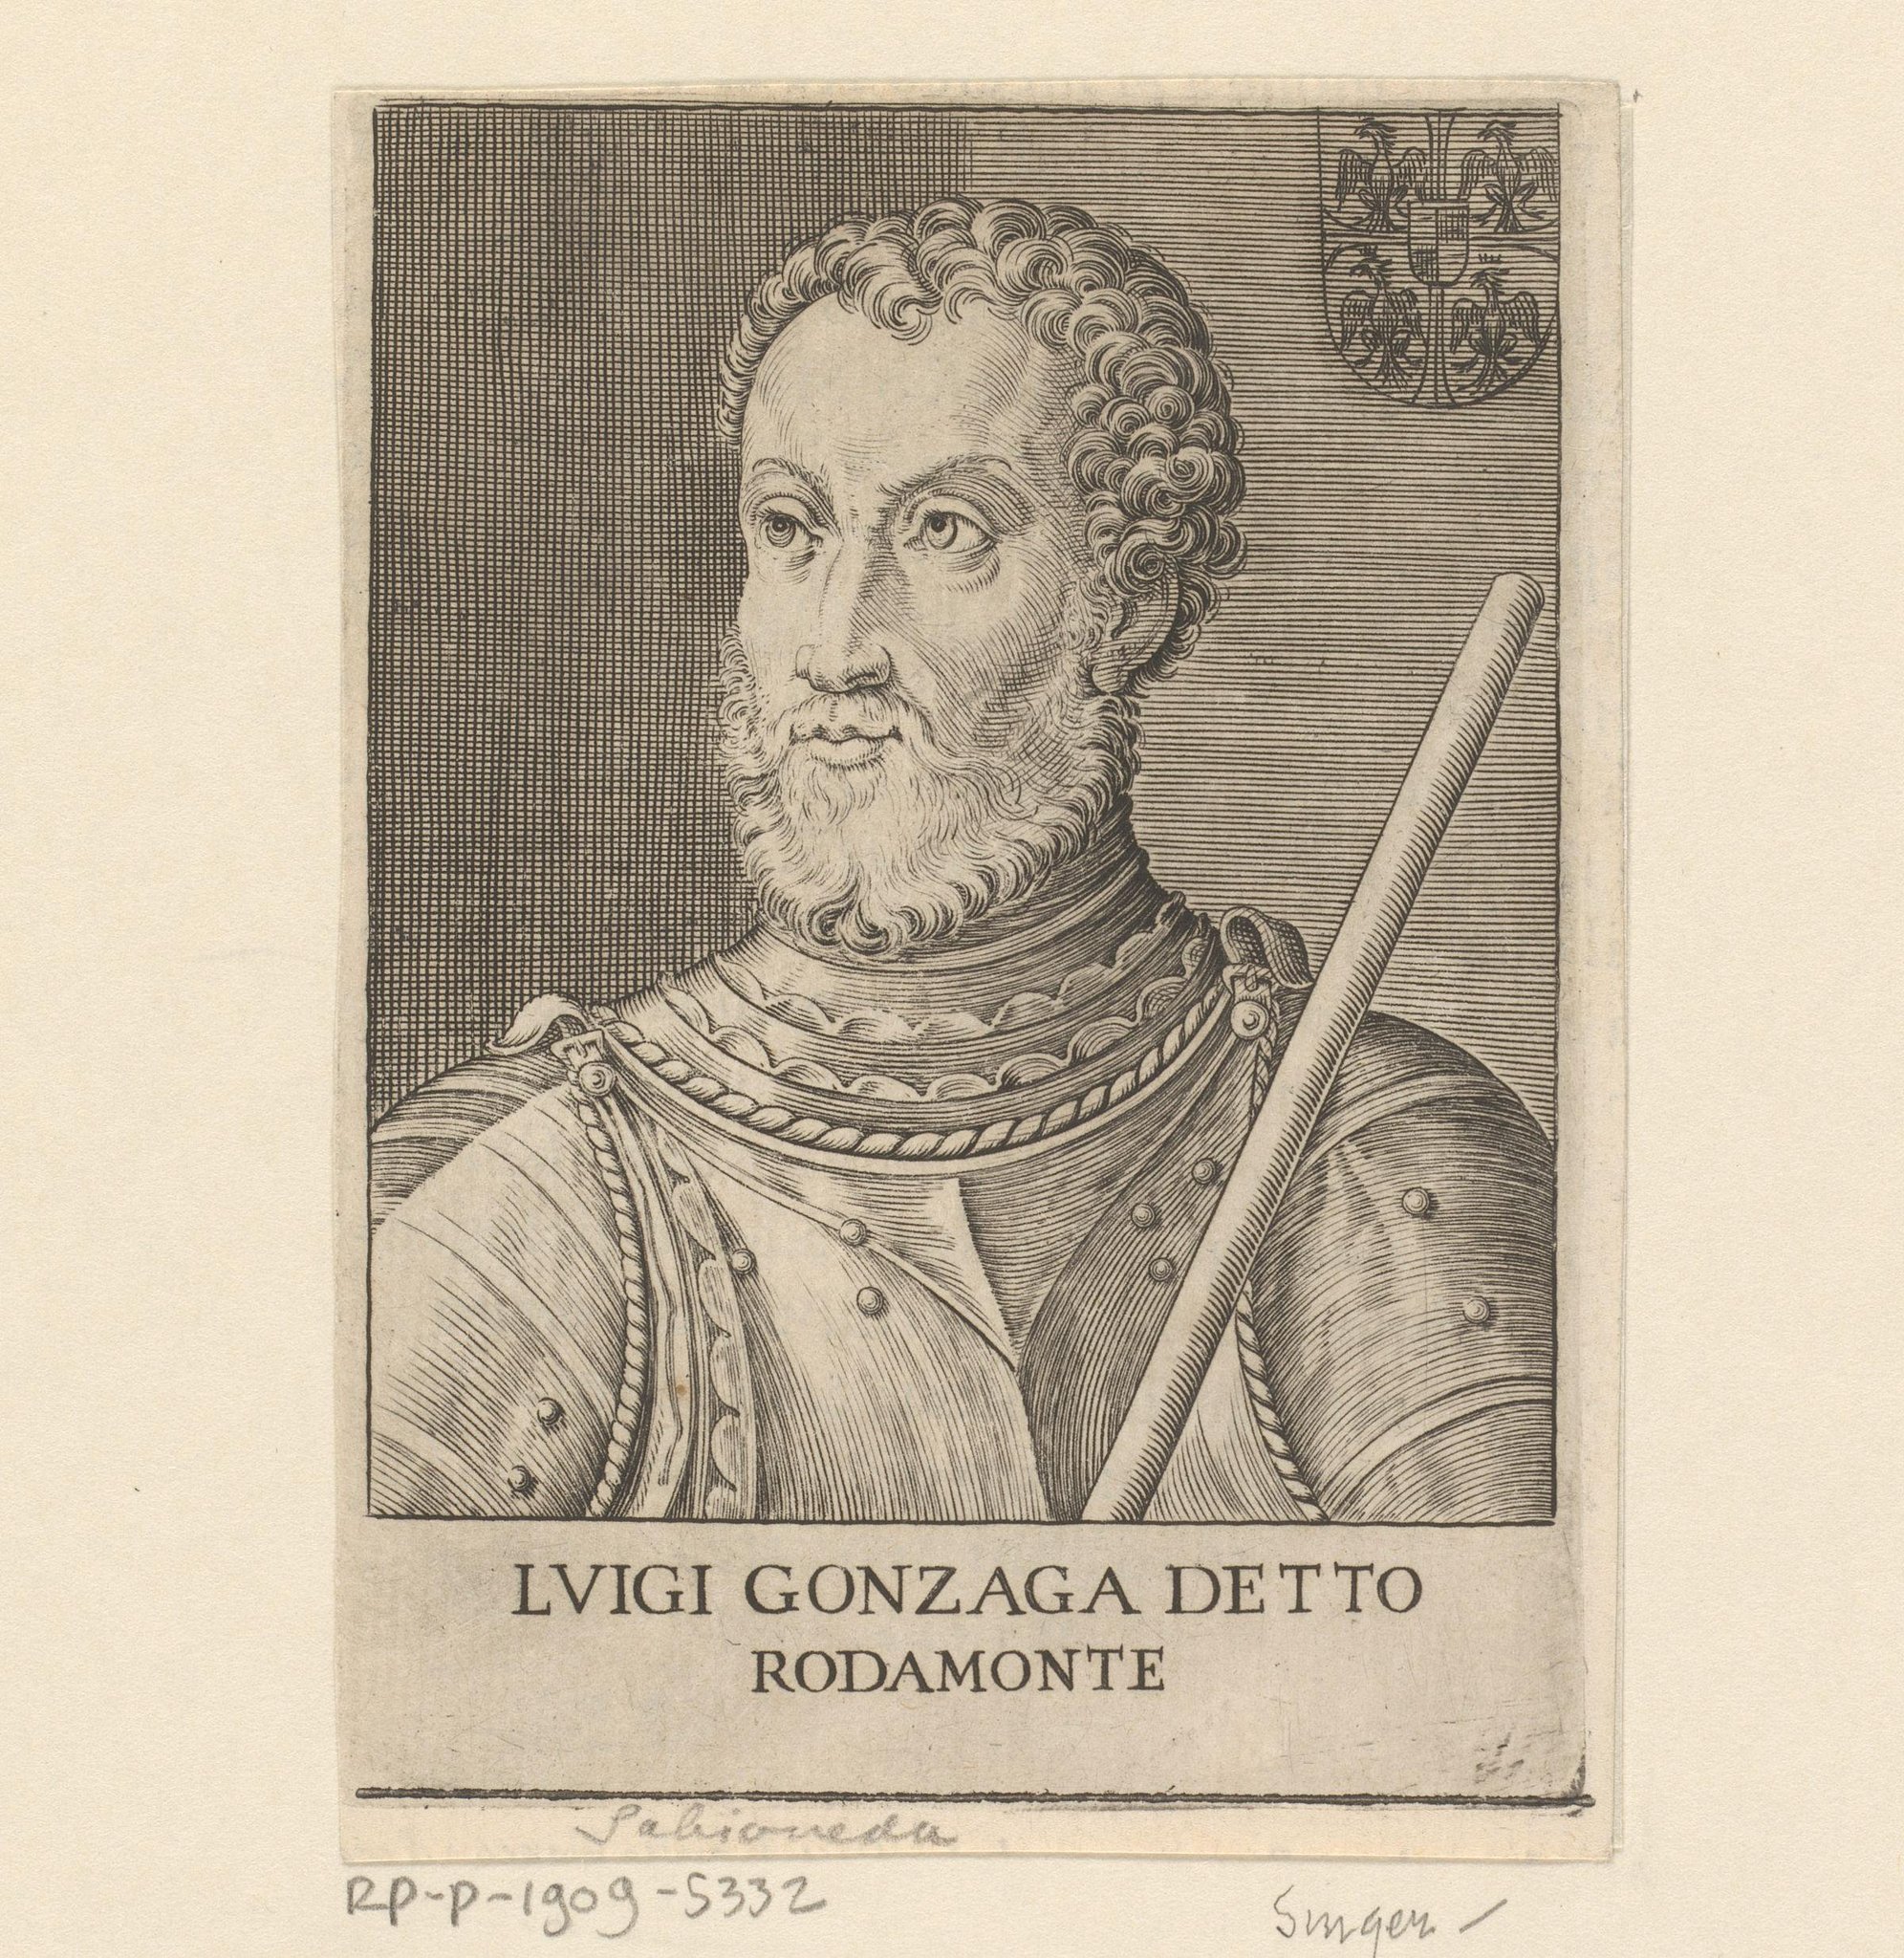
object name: print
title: Luigi Conzaga detto Rodamonte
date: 1646-1647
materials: paper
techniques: engraving, letterpress printing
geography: rome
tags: commander-in-chief, general, marshal, historical persons, armorial bearing, heraldry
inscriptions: collector's mark: Lugt 2228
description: Prent uit: Ritratti et elogii di capitani Illustri. Che ne'secoli moderni hanno gloriosamente guerreggiato. Rome: Filippo de'Rossi en Vitale Mascardi, 1646, p. 257. Prent ook gebruikt in dezelfde editie van 1647. Eerdere staten van prent in ieder geval gebruikt in: Ritratti et elogii di capitani Illustri. Rome: Pompilio Totti en Andrea Fei, 1635. En in: Ritratti di cento capitani illustri con li lor Fatti in guerra (…), Rome: Domenico Gigliotti, 1596.